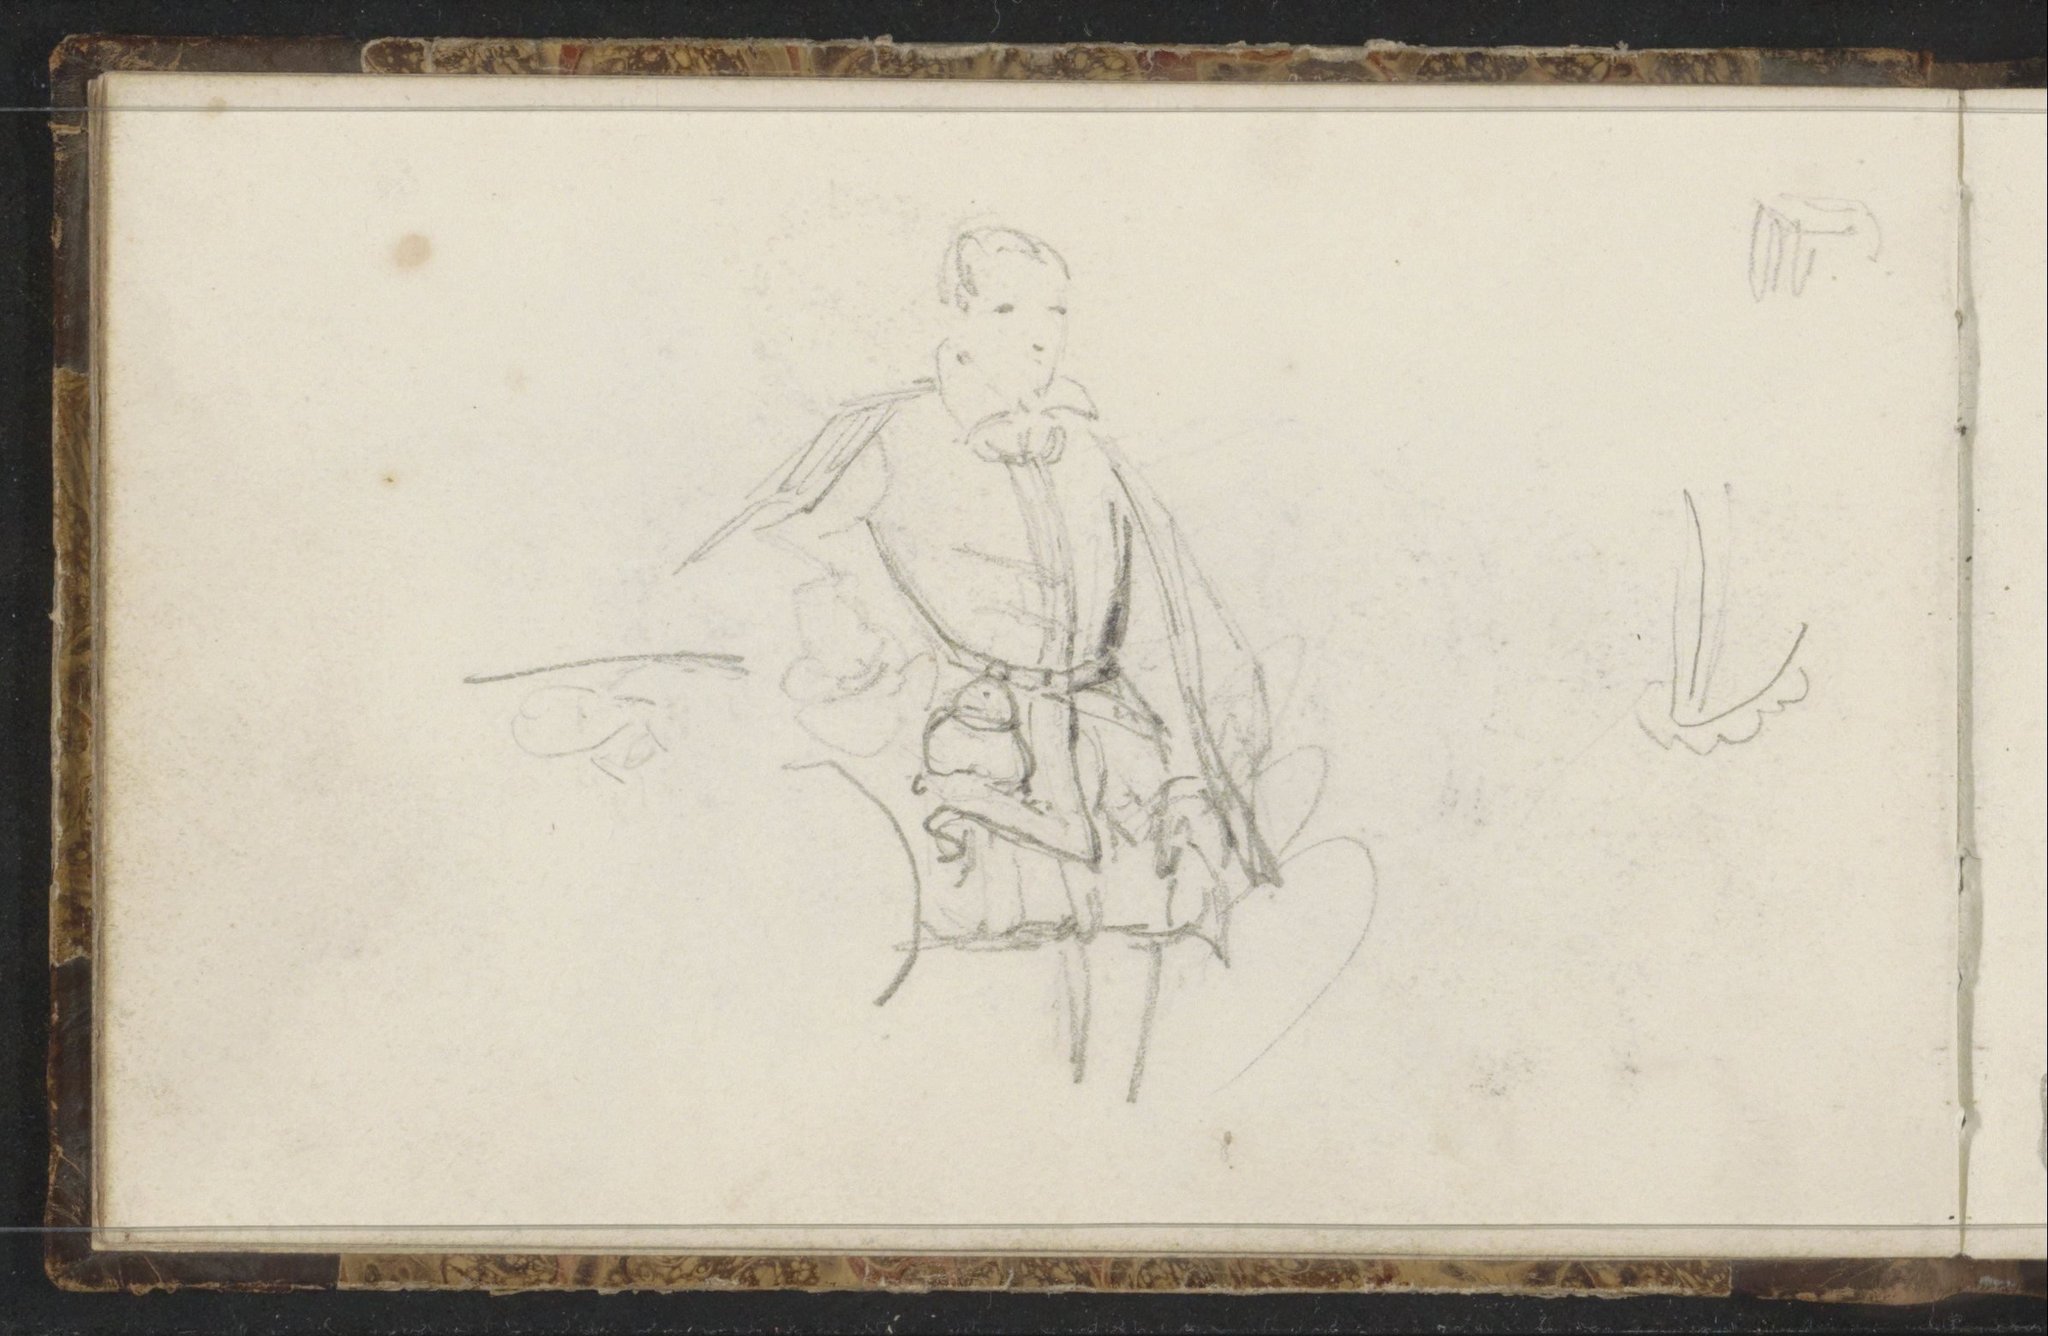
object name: sketchbook leaf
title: Staande man in historisch kostuum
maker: willem hendrik schmidt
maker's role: draughtsman, painter, print maker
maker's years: 1809-1849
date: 1819-1849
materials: paper, pencil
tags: historical costume (+ men's clothes)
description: Blad 6 verso uit een schetsboek met 60 bladen.